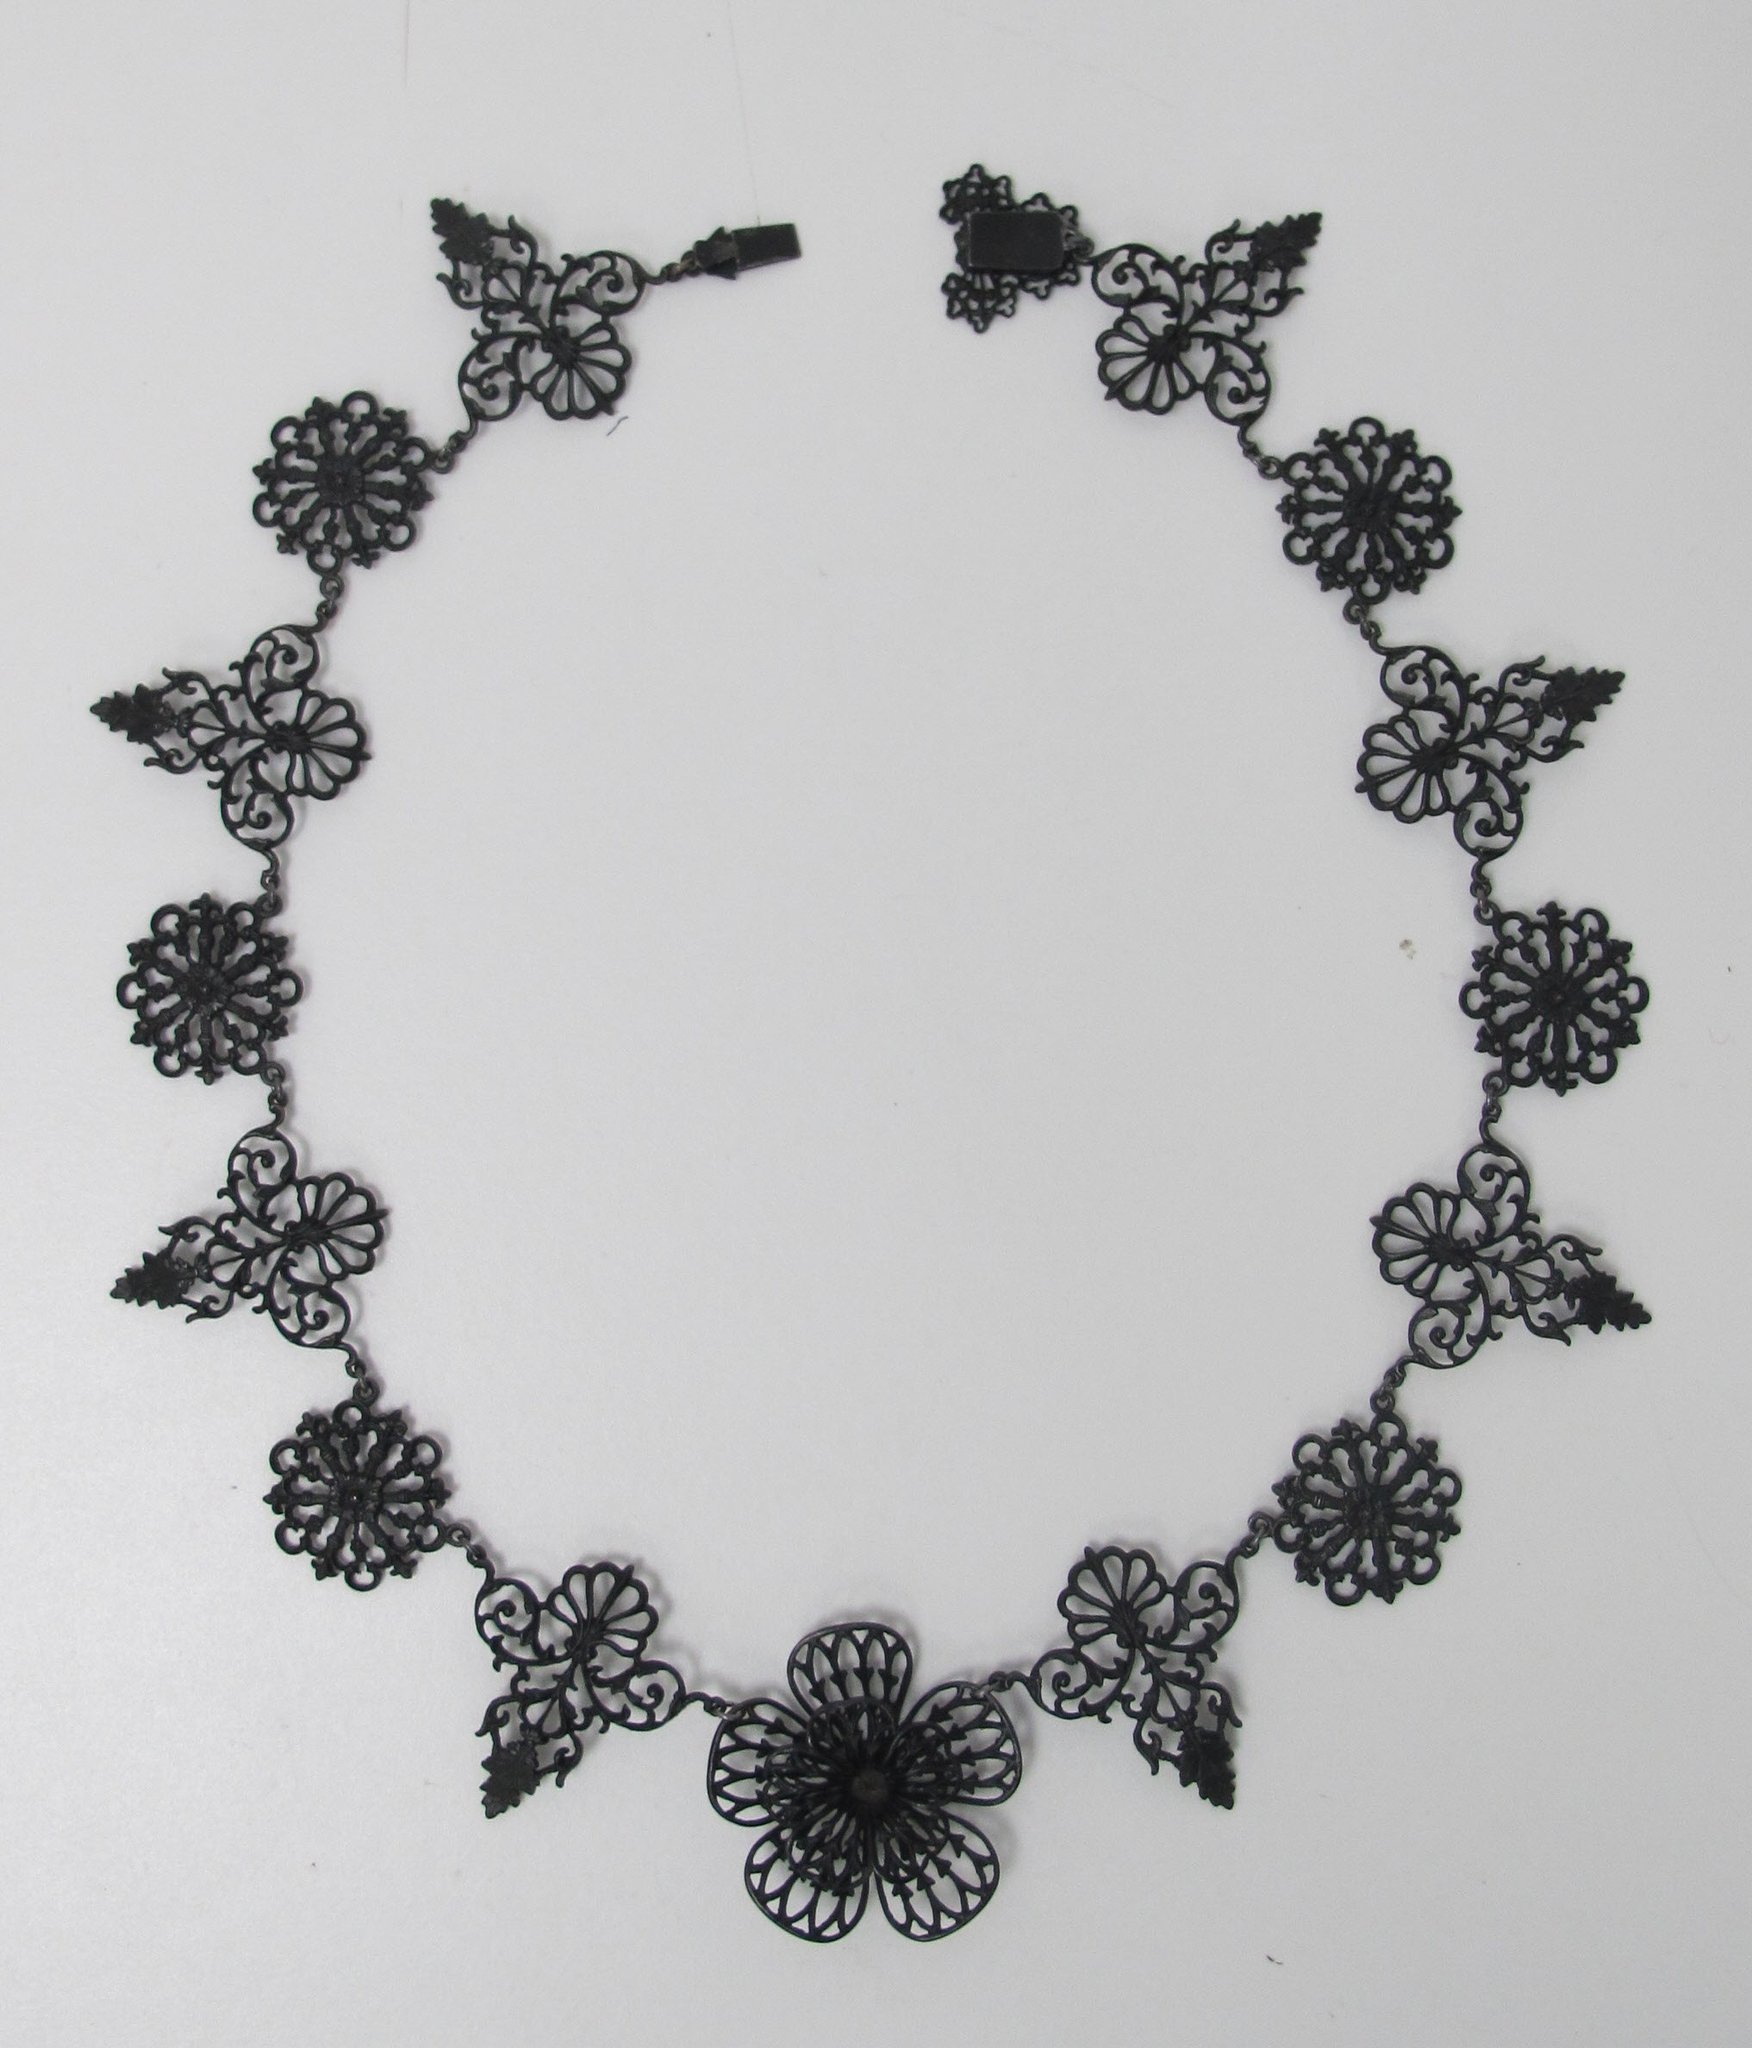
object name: necklace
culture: german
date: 1820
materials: iron